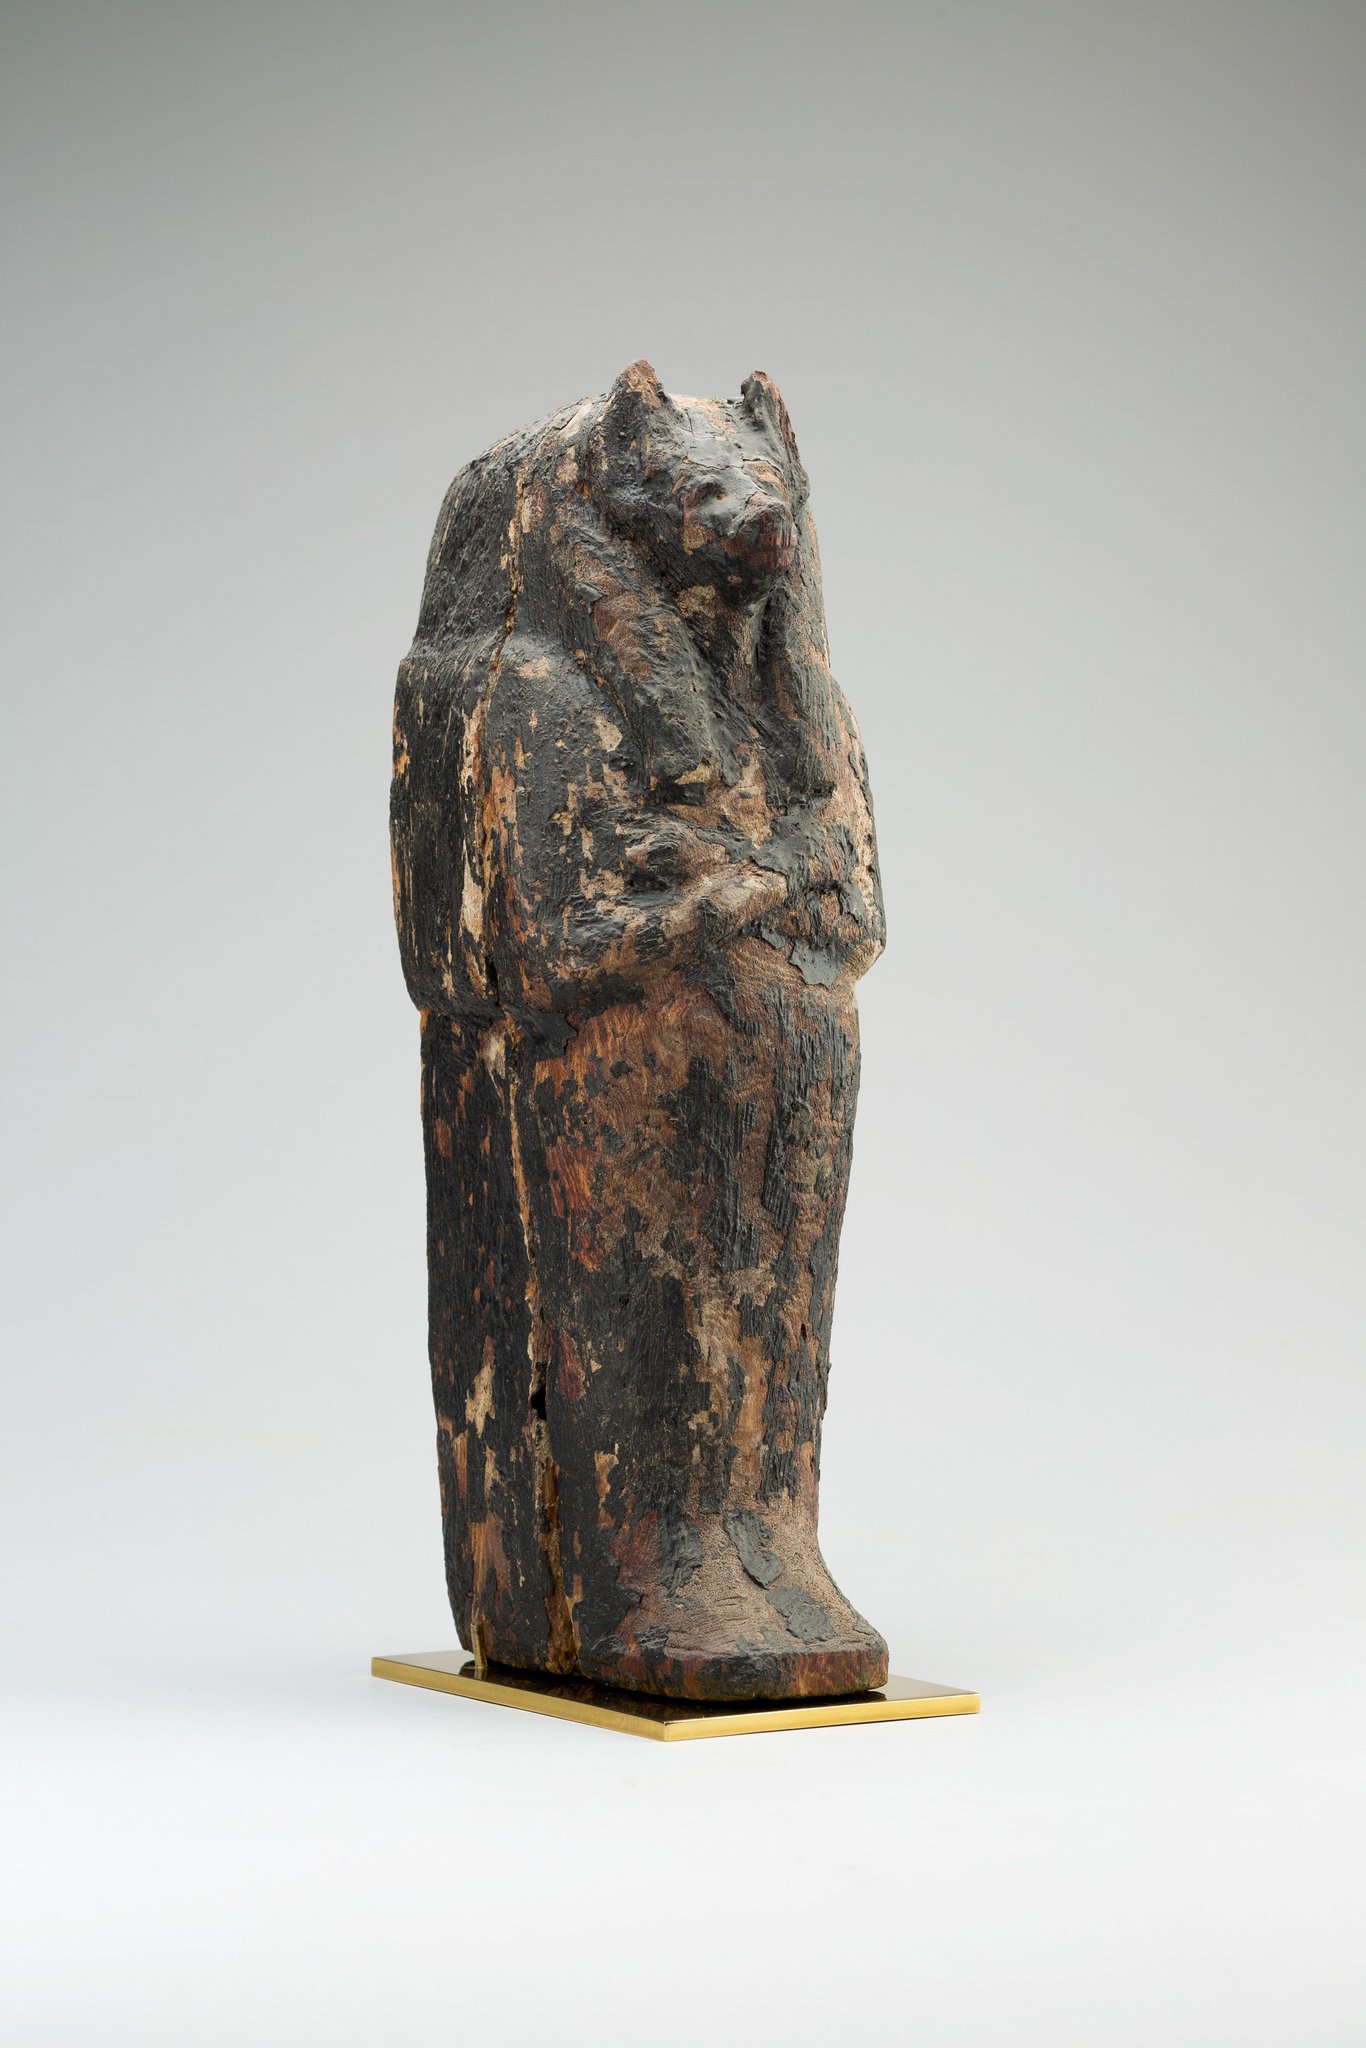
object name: canopic coffin, duamutef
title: Canopic Coffin in the Form of Duamutef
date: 924-889 BCE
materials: paint, plaster, wood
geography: egypt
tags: coffins